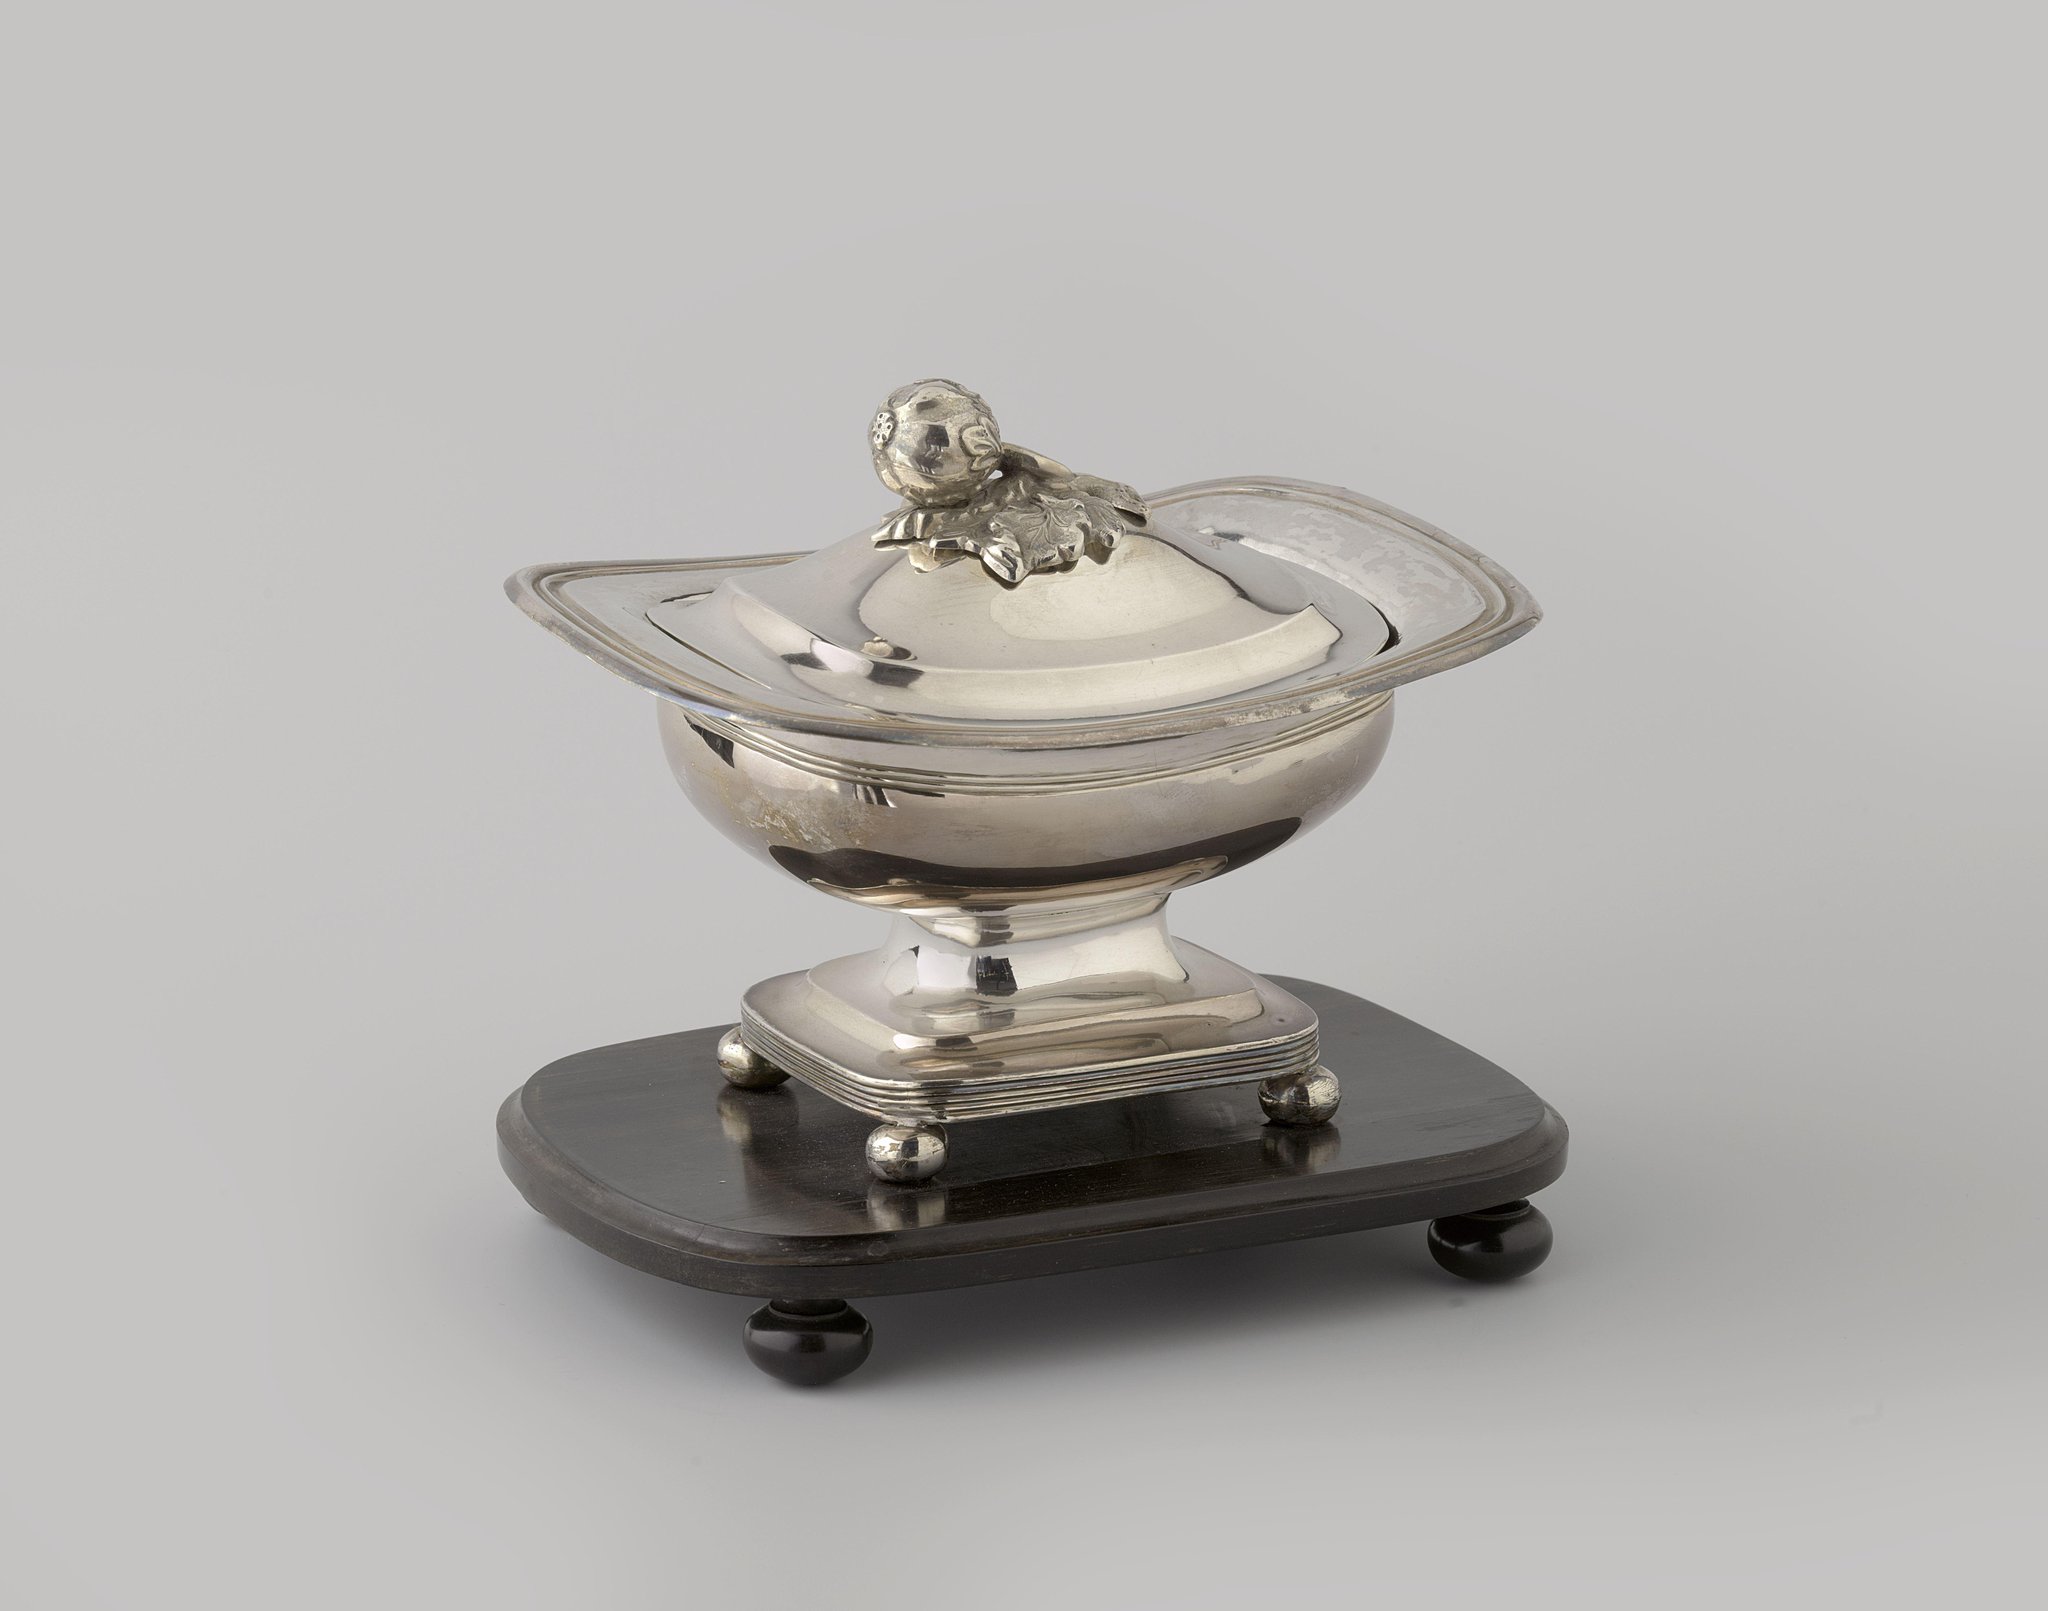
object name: tobacco jar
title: Tabakspot met deksel van zilver, met hoge voet op blad van ebbenhout. Dekselknop in de vorm van vruchtenblad.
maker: jacobus schalkwijk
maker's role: silversmith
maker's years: 1793-1847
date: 1842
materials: wood, silver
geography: rotterdam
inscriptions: mark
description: Tabakspot van zilver, met deksel en op een hoge voet staande op een blad van ebbenhout. De deksel knop heeft de vorm van een vruchtenblad.